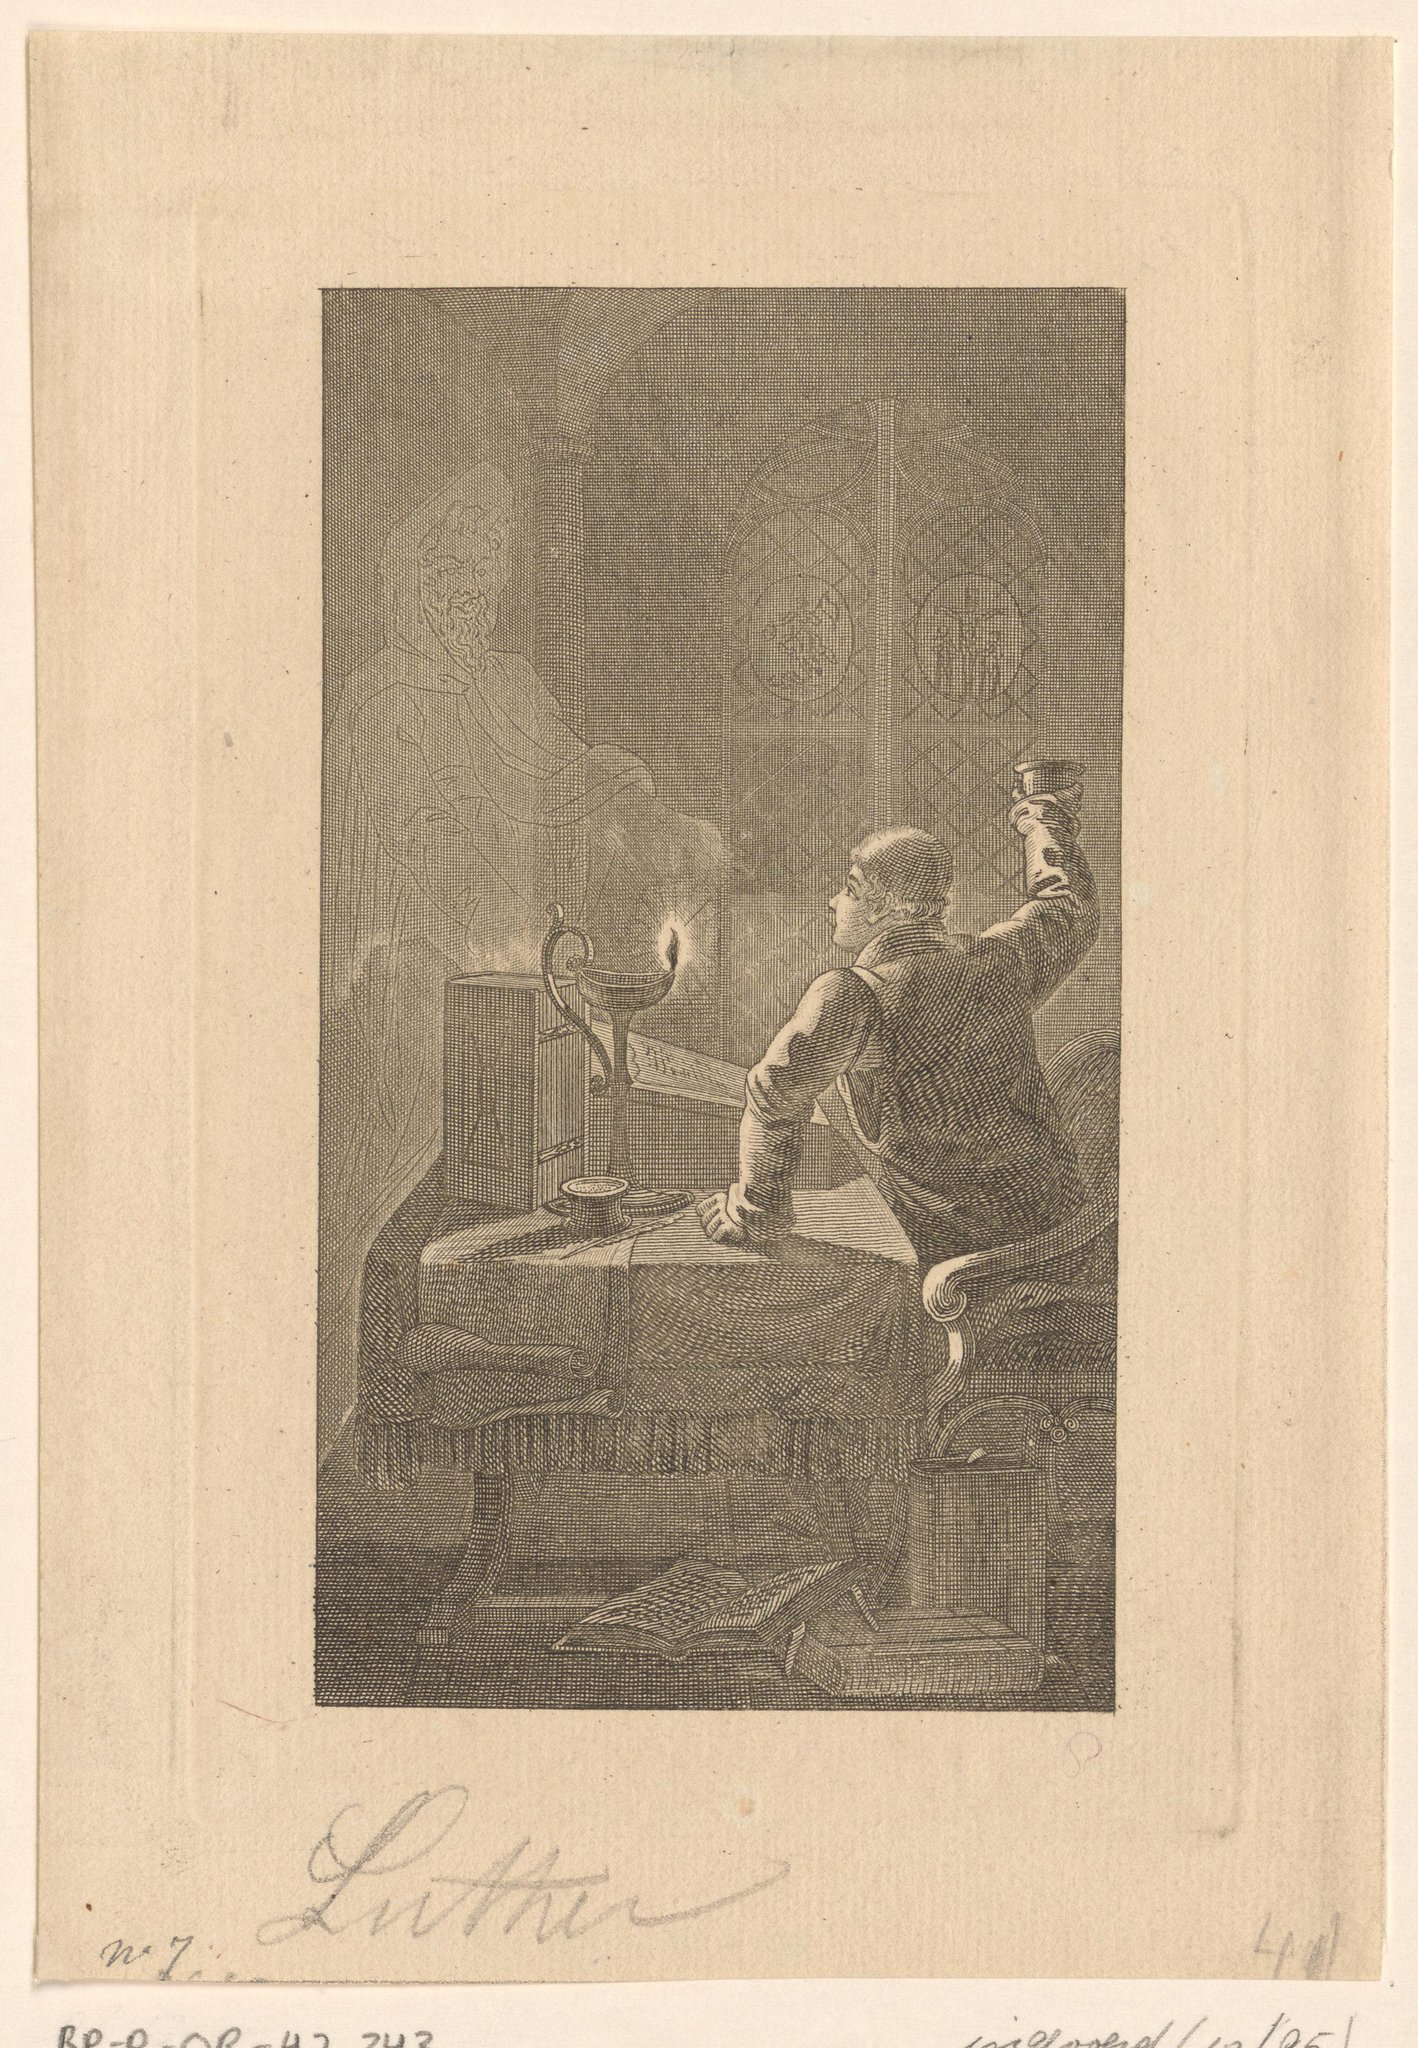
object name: print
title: Verschijning aan Martin Luther op Wartburg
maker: Anonymous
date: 1700-1799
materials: paper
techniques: etching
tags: priest, martin luther, writing-table, writing-desk, historical persons, human-shaped devil, banishment, exile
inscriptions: collector's mark: Lugt 2228